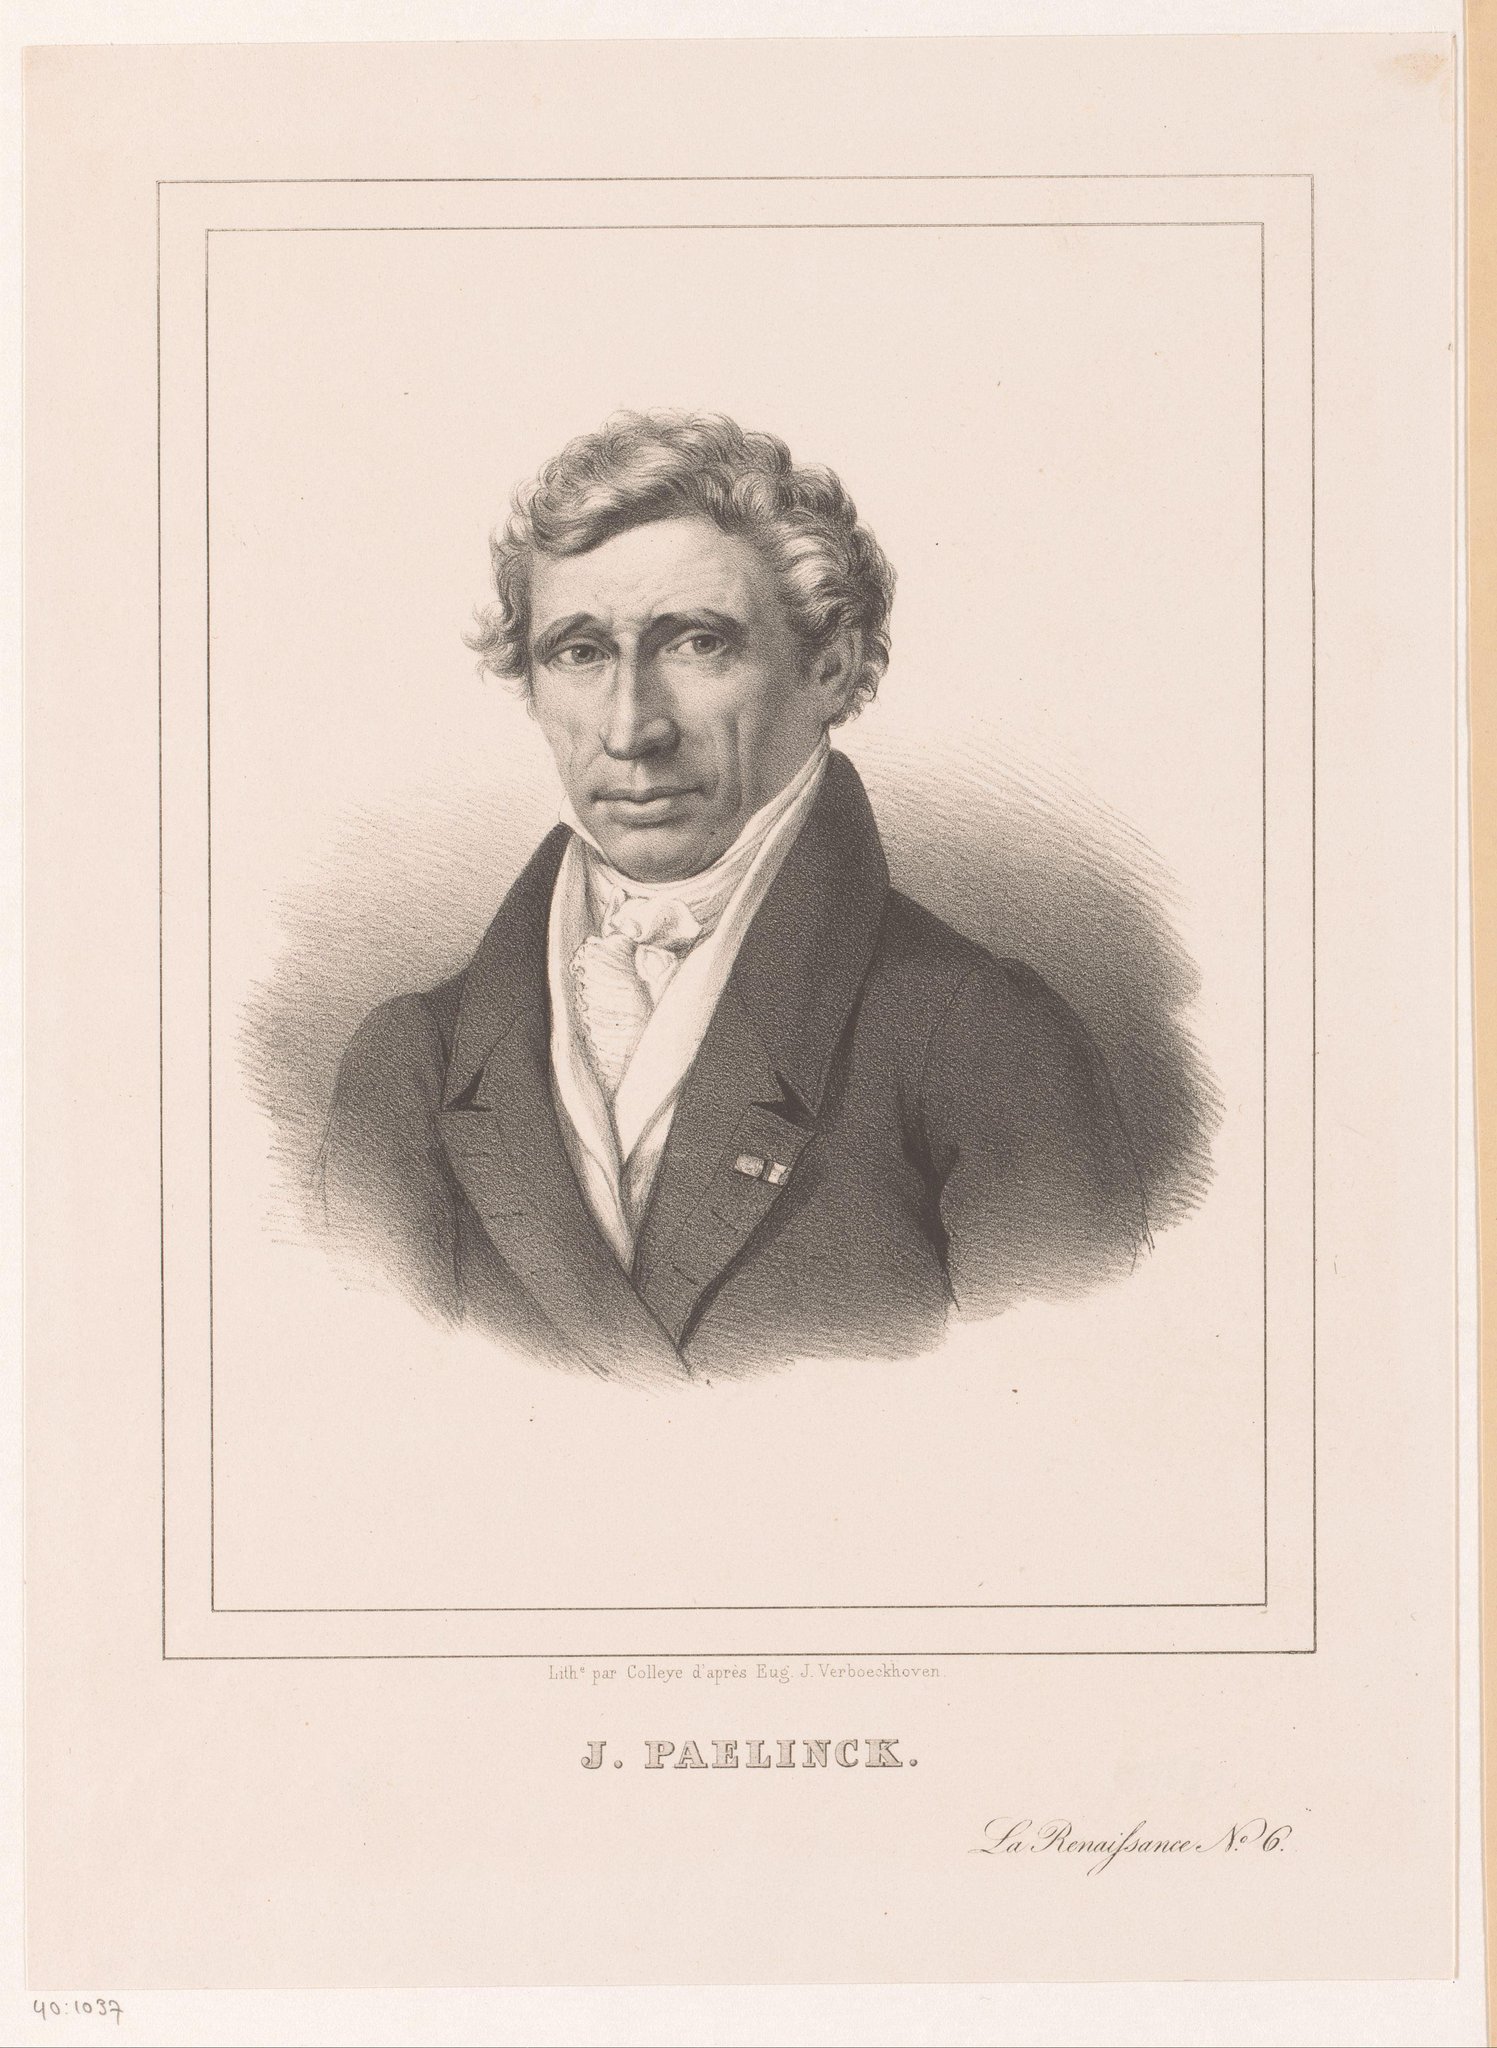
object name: print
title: J. Paelinck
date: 1839-1849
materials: paper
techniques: lithograph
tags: brussels, painter, joseph paelinck, adult man, historical persons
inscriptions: collector's mark: Lugt 2760, collector's mark: Lugt 2228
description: Prent is verschenen in een uitgave van: La Renaissance. Chronique des arts et de la littérature [1839-1849], pl. 6.